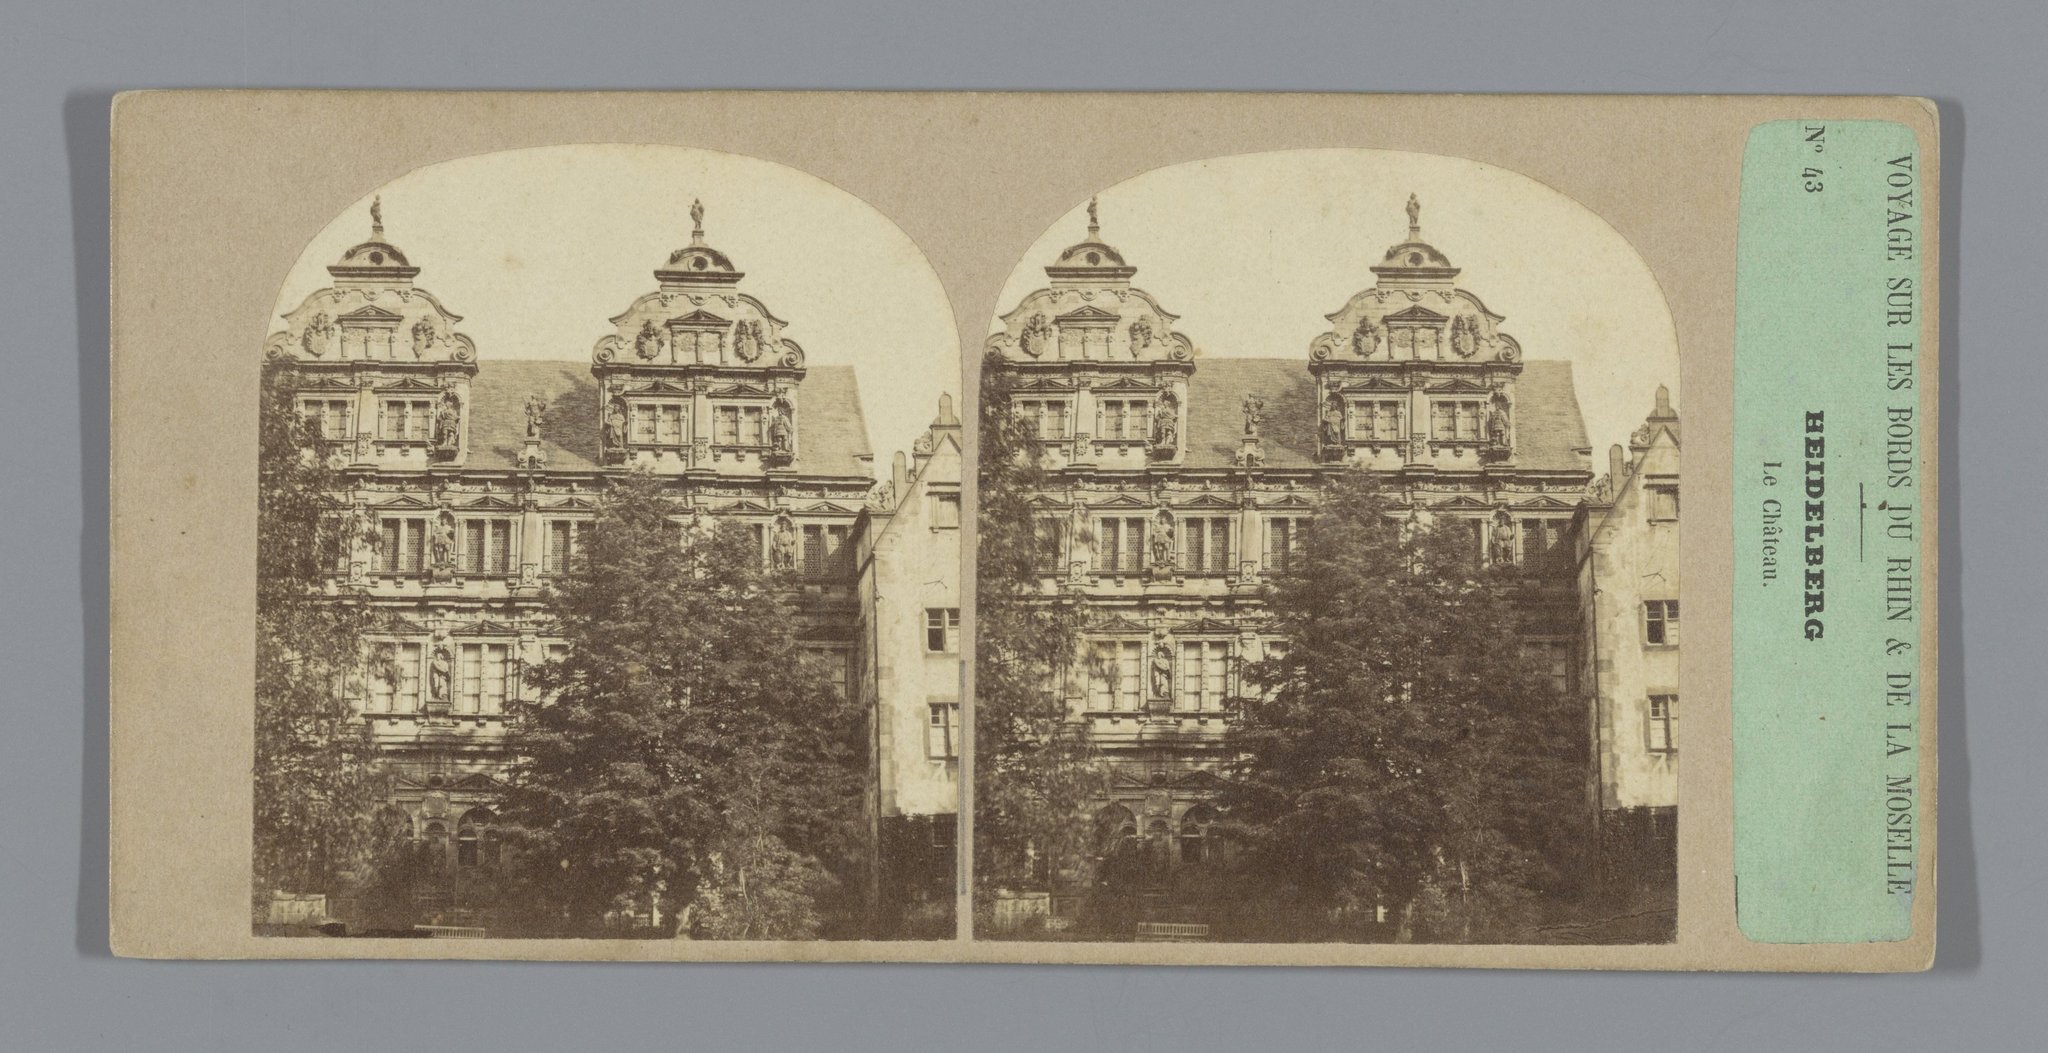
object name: stereograph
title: Heidelberg, le château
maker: Anonymous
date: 1860-1880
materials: cardboard, photographic support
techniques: albumen print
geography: heidelberg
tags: castle, façade (of house or building)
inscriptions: number: ‘No 43’, inscription: ‘2976. ng/ig’